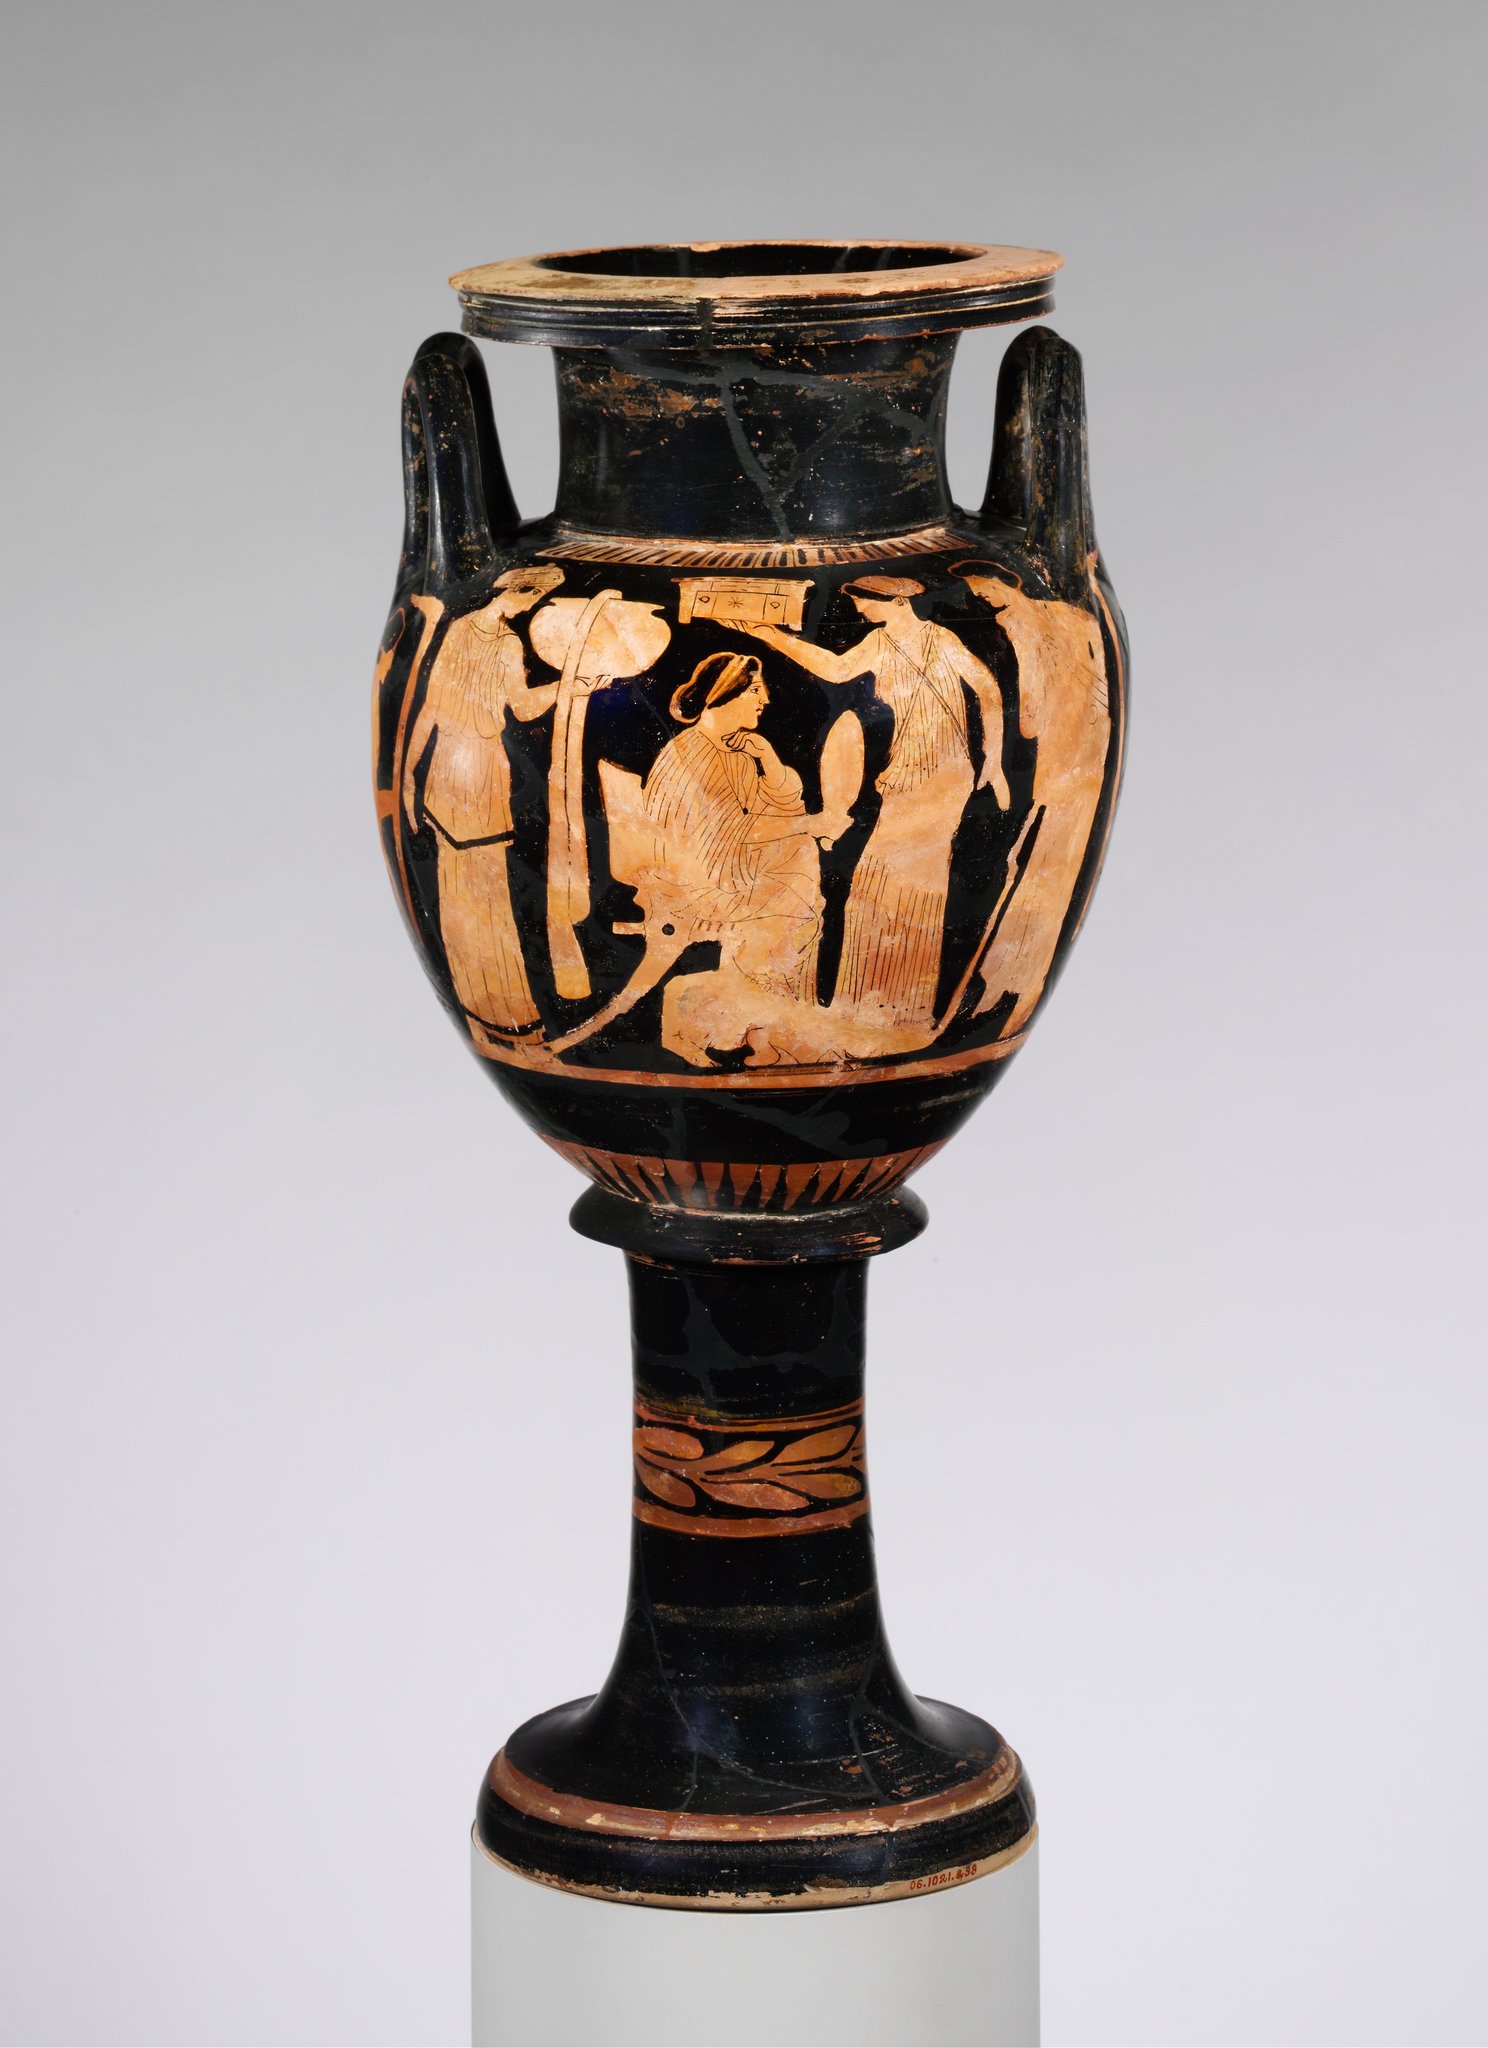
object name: lebes gamikos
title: Terracotta lebes gamikos (round-bottomed bowl with handles and stand used in weddings)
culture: greek, attic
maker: naples painter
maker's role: artist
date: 420 BCE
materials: terracotta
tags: men,women,mirrors